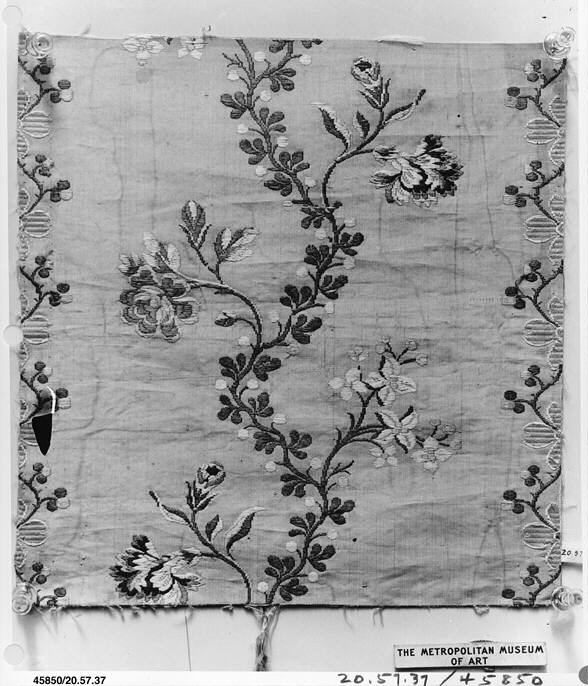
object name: piece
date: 1760-1770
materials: silk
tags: flowers,leaves